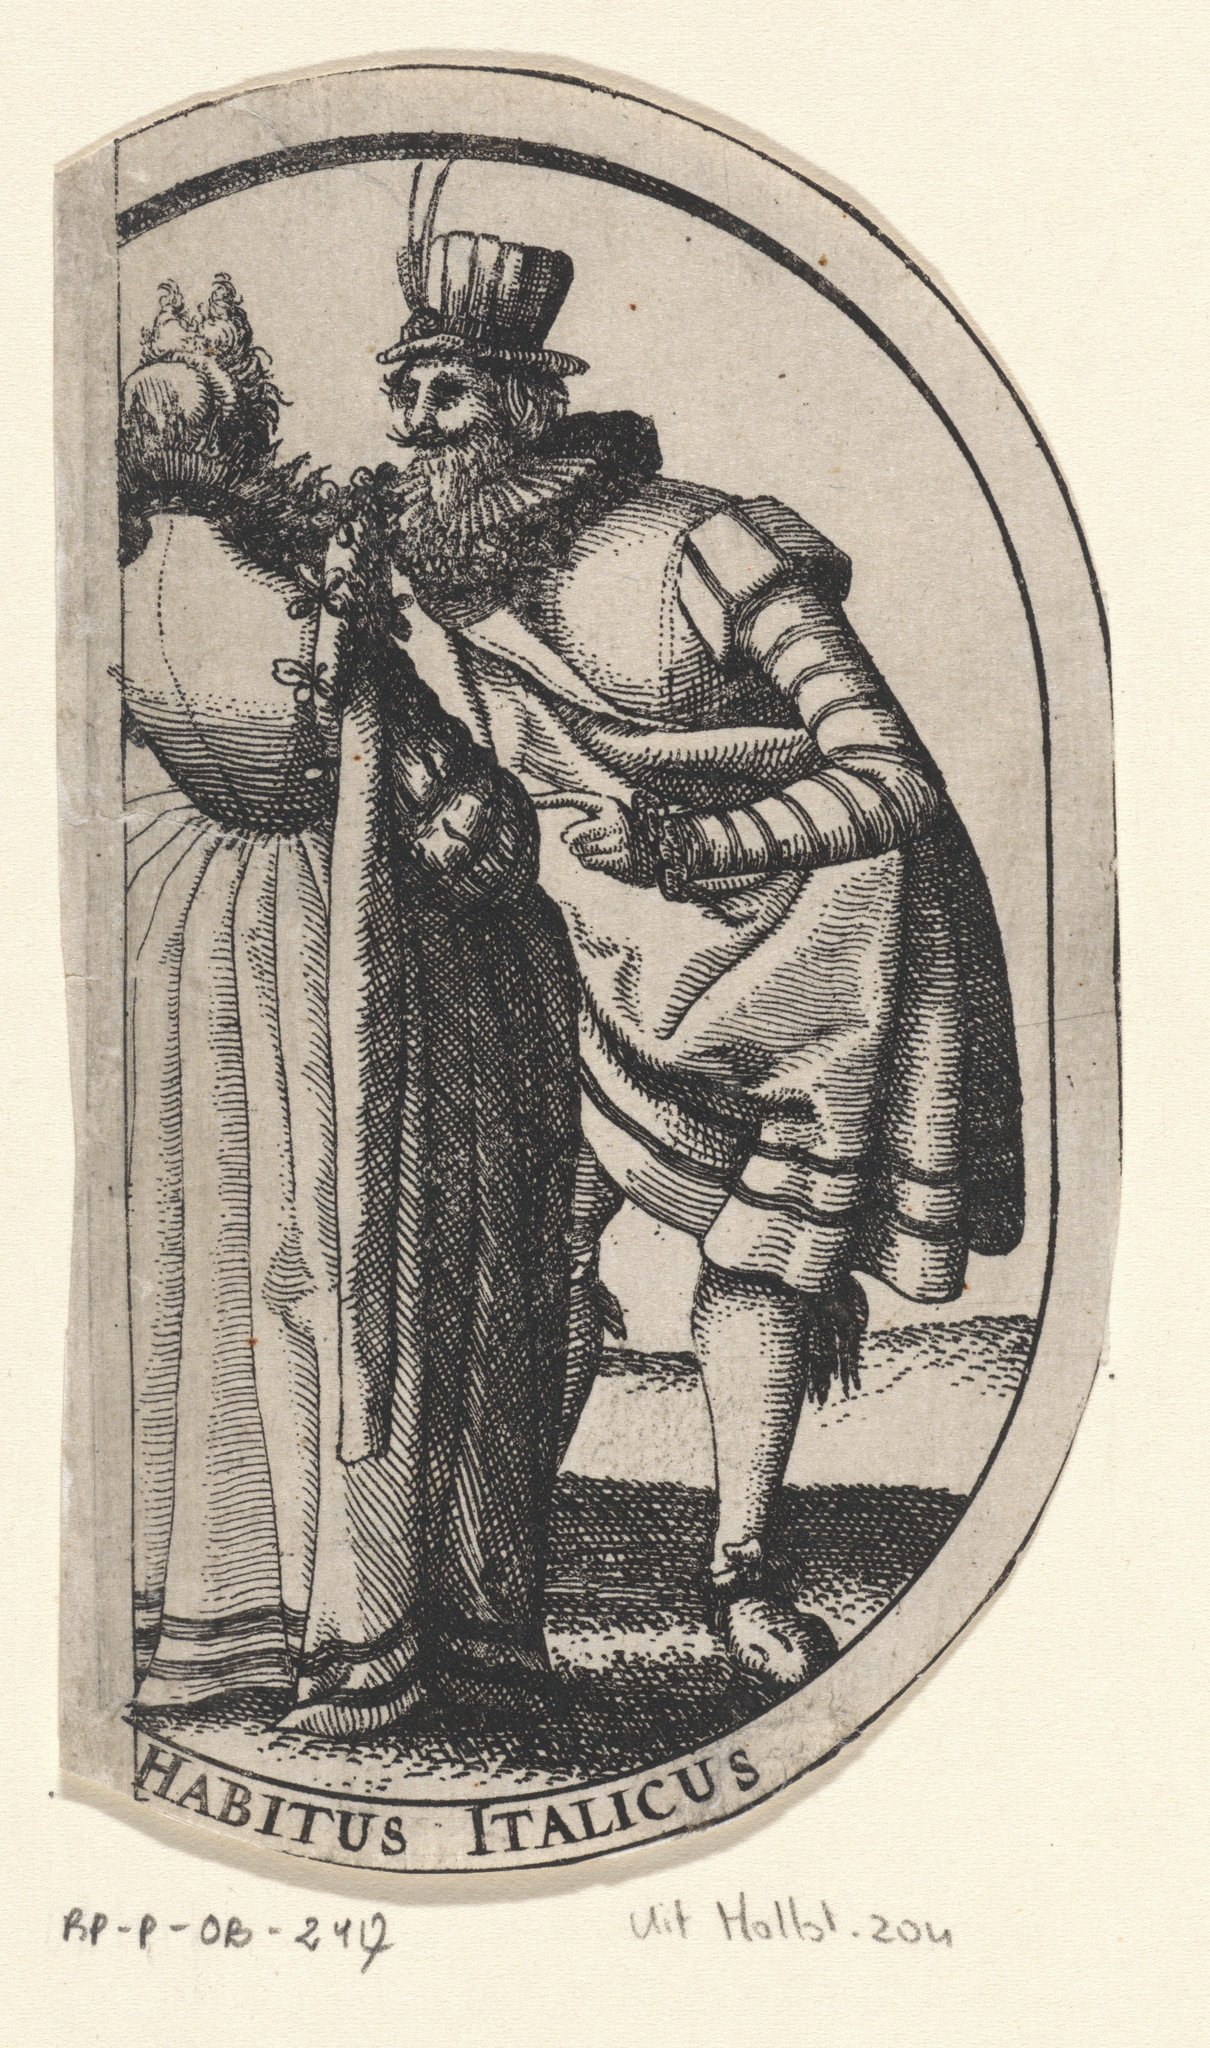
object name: costume print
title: Elegant paar in Italiaanse kleding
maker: claes jansz. visscher (ii)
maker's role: draughtsman, print maker, publisher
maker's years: 1586-1652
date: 1607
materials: paper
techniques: etching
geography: amsterdam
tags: cape (+ men's clothes), head-gear: hat (+ men's clothes), clothes, costume (+ women's clothes), dress, gown (+ women's clothes), clothes, costume (+ men's clothes), europeans (with name) (+ costume), head-gear: hat (+ feathers used for clothes)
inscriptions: collector's mark: Lugt 2228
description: Deze prent is afkomstig uit de rand van de wereldkaart die in 1607 werd uitgegeven door Herman Allartsz. Koster en David de Meyne, Hollstein nr. 204.